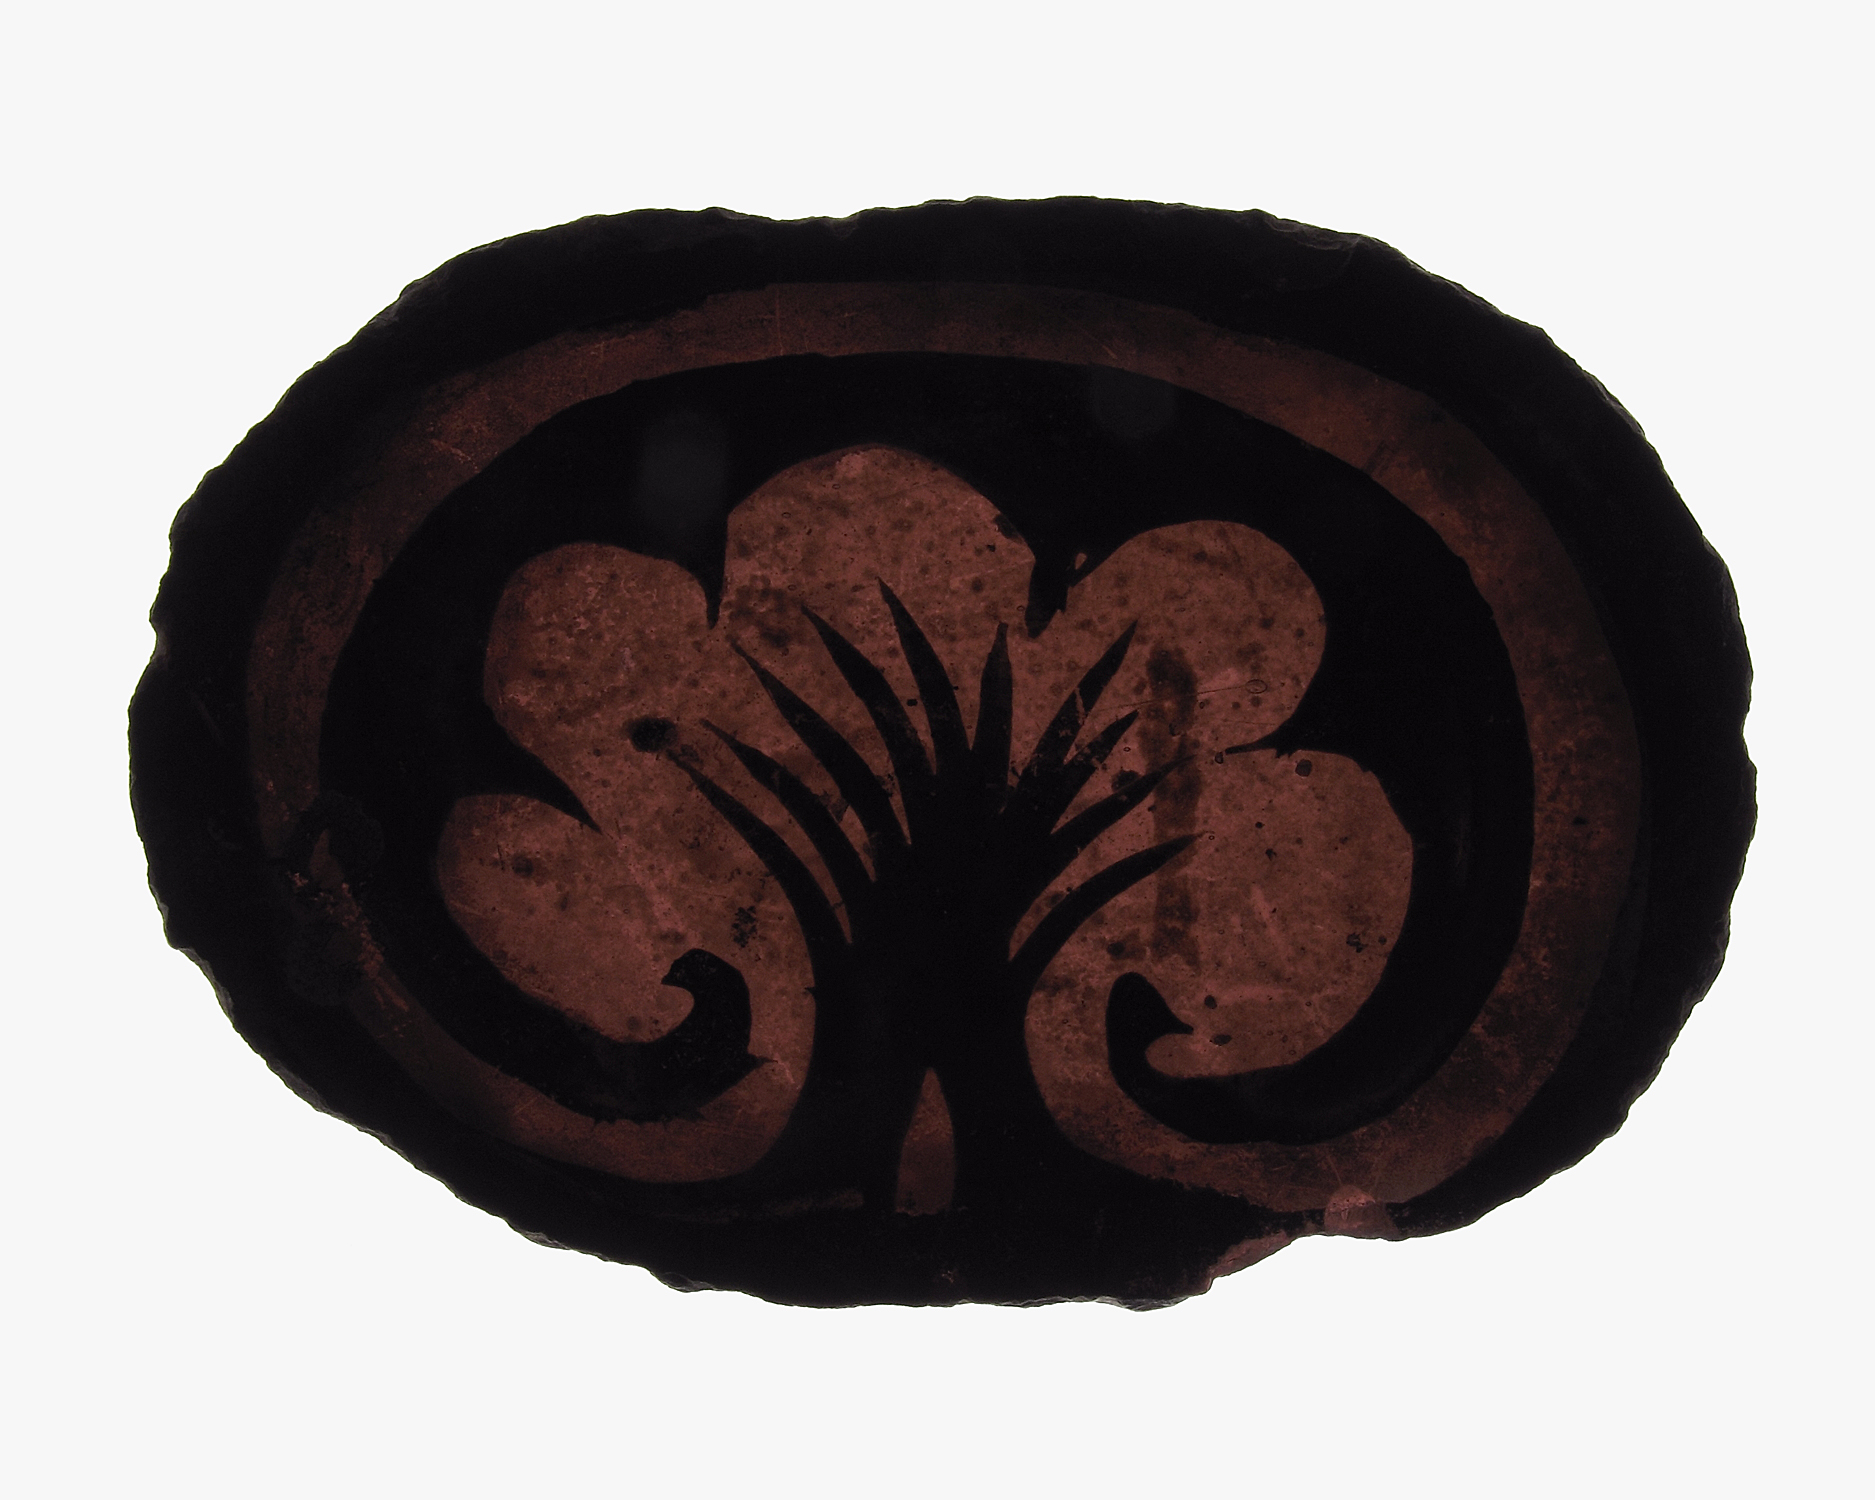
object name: fragment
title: Glass Fragment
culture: european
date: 1201-1400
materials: glass, metal